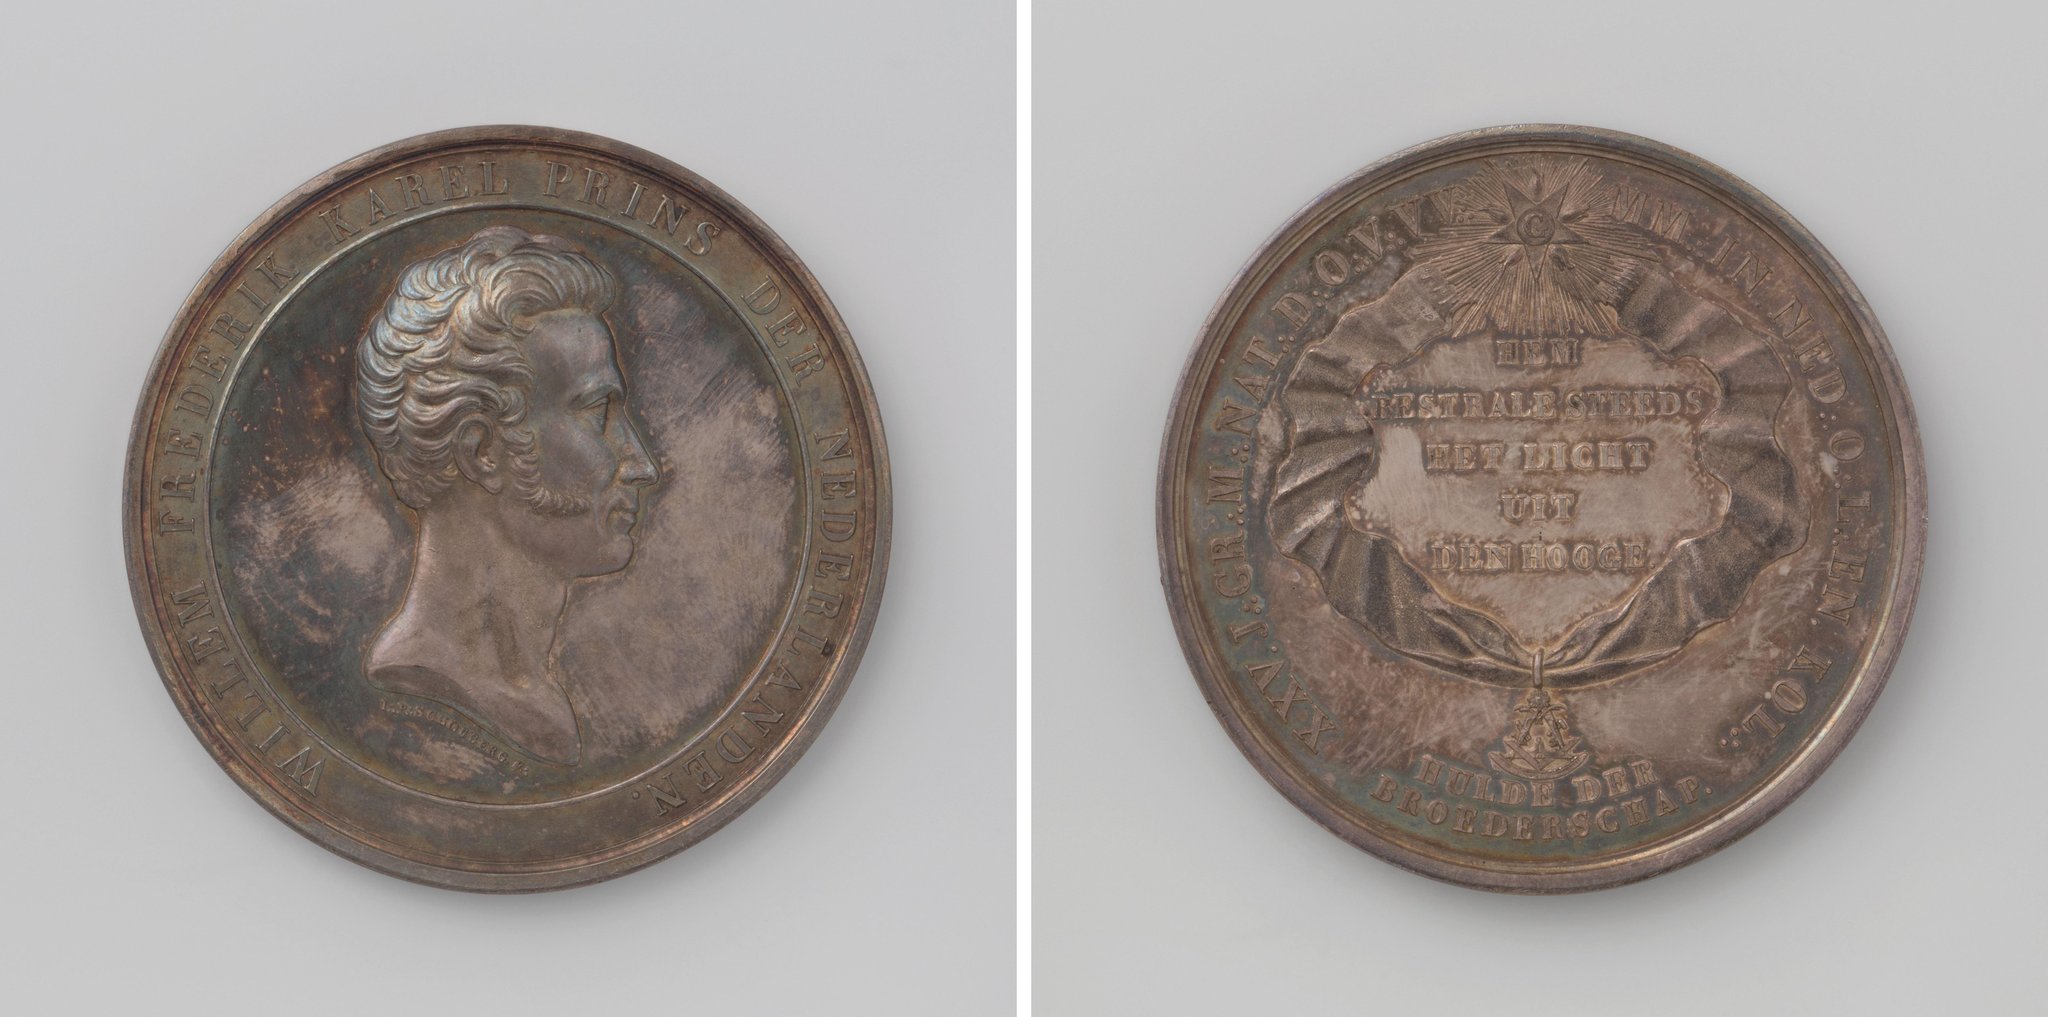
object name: history medal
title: Frederik, prins der Nederlanden, vijfentwintig jaar grootmeester van de "Grande Loge d'Administration"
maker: johannis petrus schouberg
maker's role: die cutter, draughtsman, print maker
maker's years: 1798-1864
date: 1841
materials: silver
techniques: striking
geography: utrecht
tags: frederik (prins der nederlanden), the hague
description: Zilveren penning. Voorzijde: borststuk man binnen omschrift. Keerzijde: opschrift binnen lint van orde van het Grootmeesterschap, beschenen door vijfhoekige ster met letter G erin binnen omschrift.